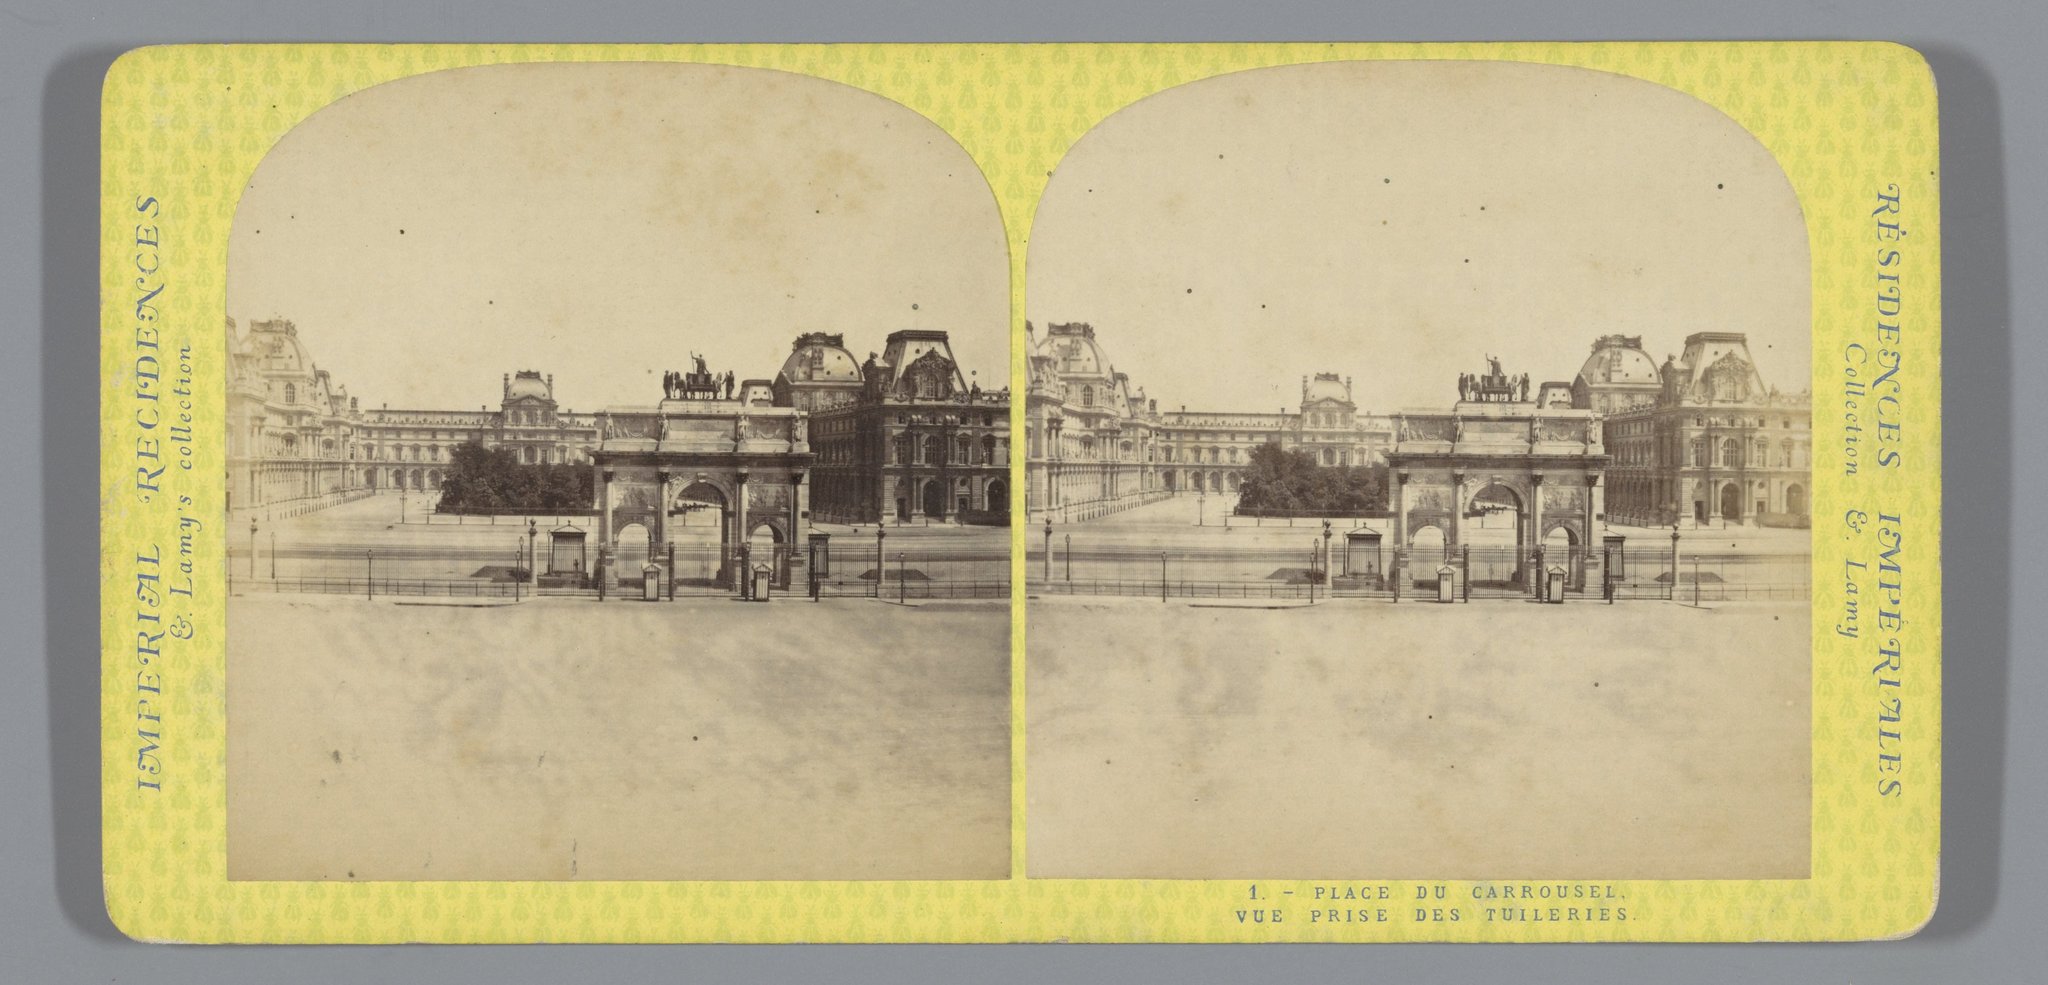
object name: stereograph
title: Place du Carrousel te Parijs, gezien vanaf het Palais des Tuileries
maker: ernest eléonor pierre lamy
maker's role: publisher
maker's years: 1828-1900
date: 1860-1871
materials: cardboard, photographic support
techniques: albumen print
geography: tuileries palace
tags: square, place, circus, etc., triumphal arch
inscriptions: number: ‘1.’, inscription: ‘E. Lamy's collection’